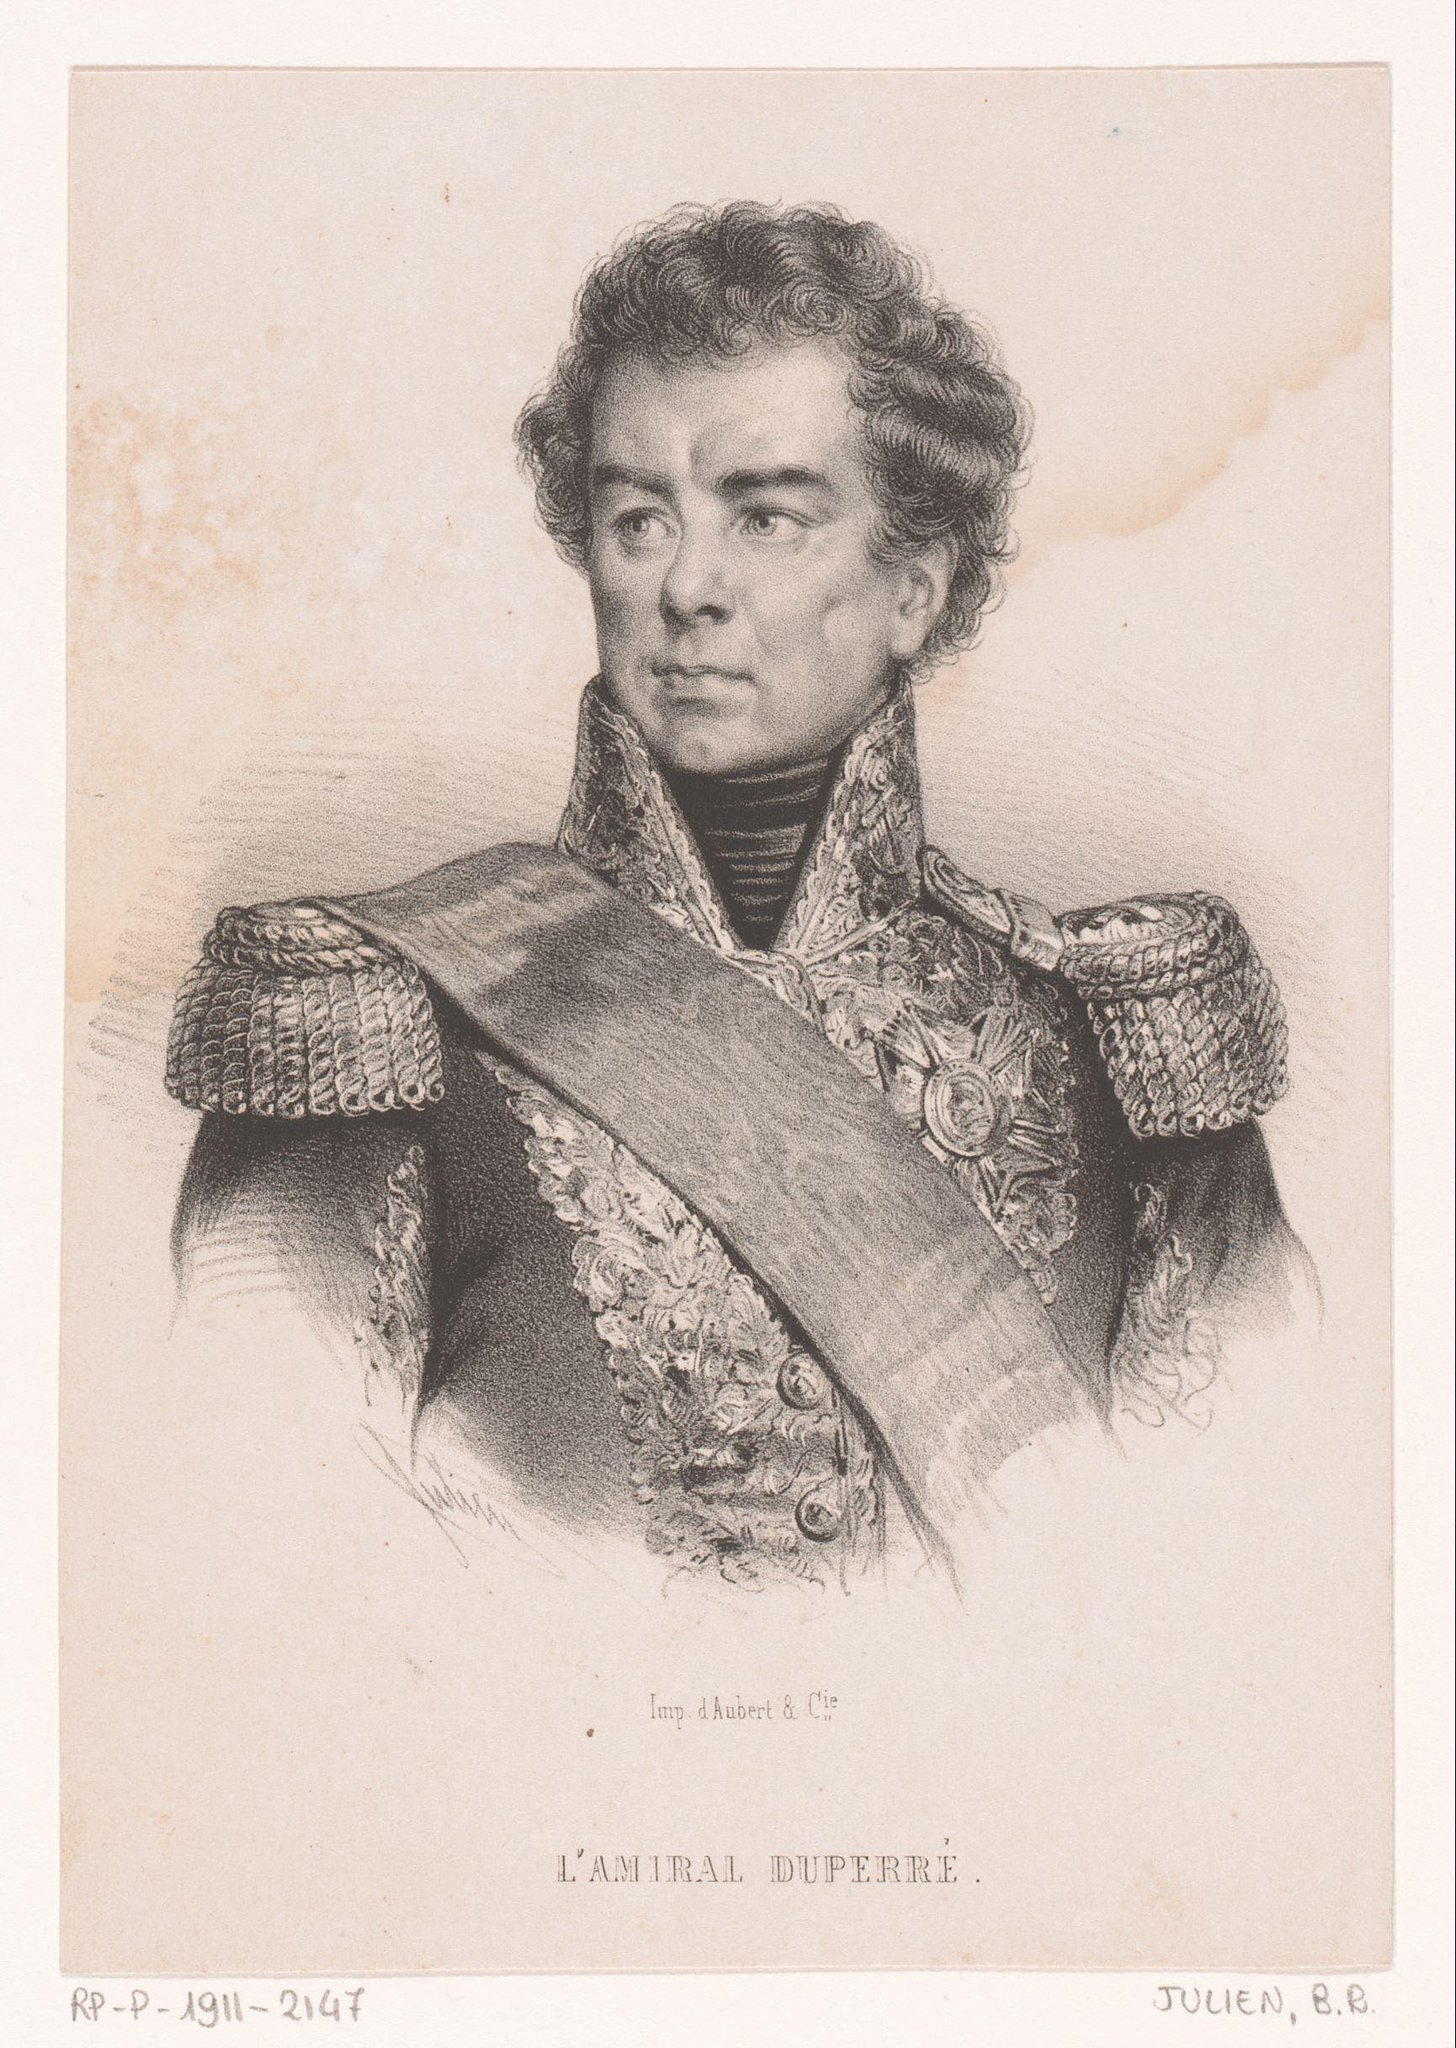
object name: print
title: Galerie du Journal le Voleur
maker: bernard romain julien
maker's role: print maker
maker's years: 1802-1871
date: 1841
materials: paper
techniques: lithograph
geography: paris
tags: paris, historical persons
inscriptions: collector's mark: Lugt 2228a